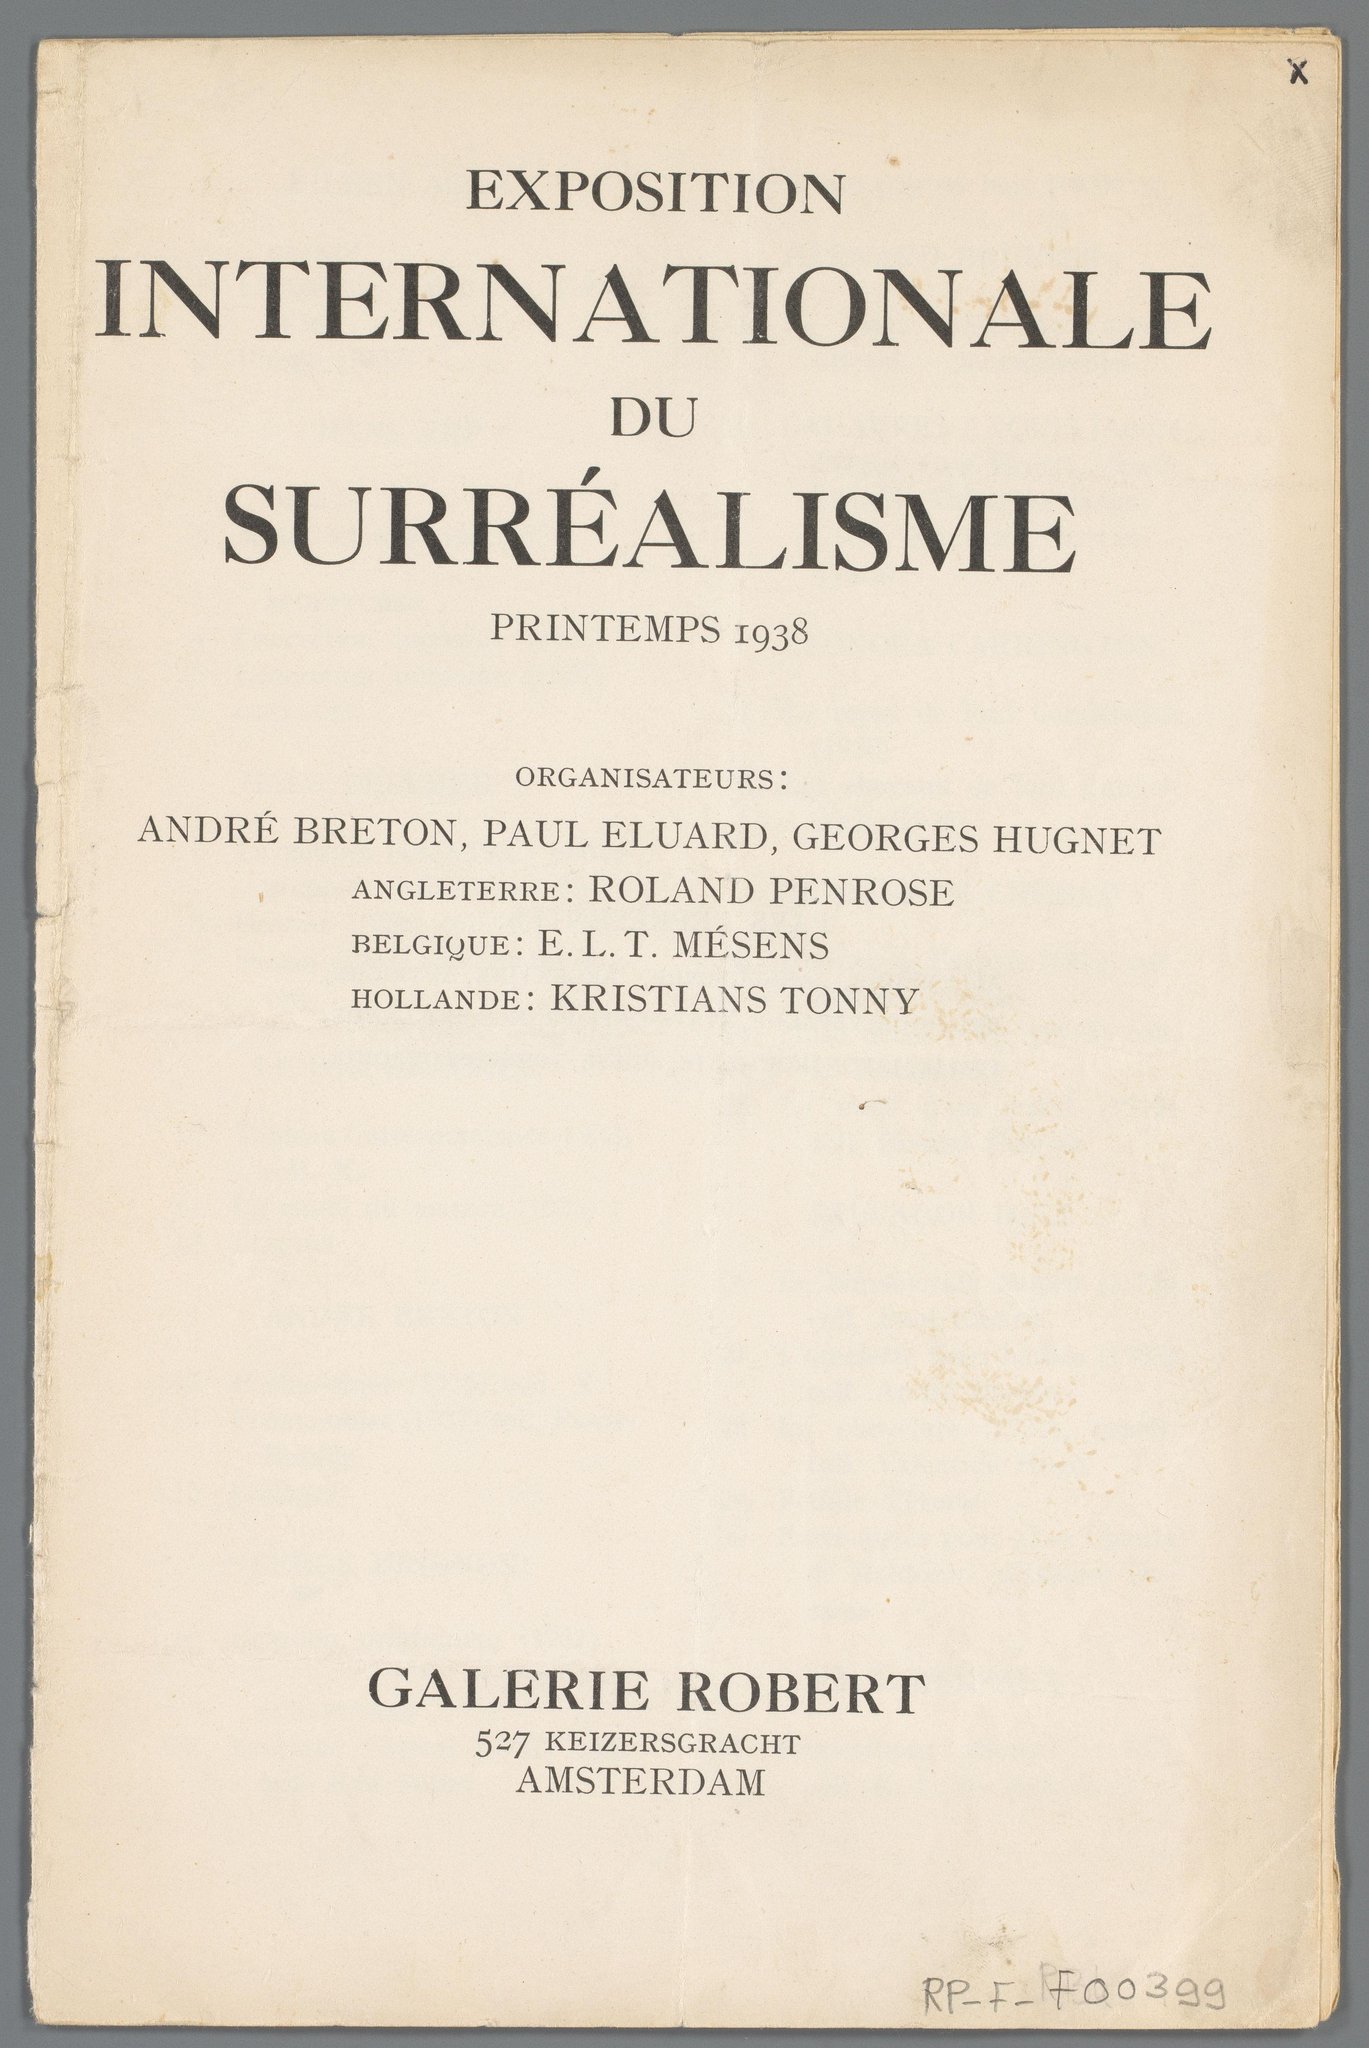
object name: catalog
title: Exposition Internationale du Surréalisme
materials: paper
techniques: printing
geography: amsterdam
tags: printed matter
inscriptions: address: ‘527 KEIZERSGRACHT/ AMSTERDAM’